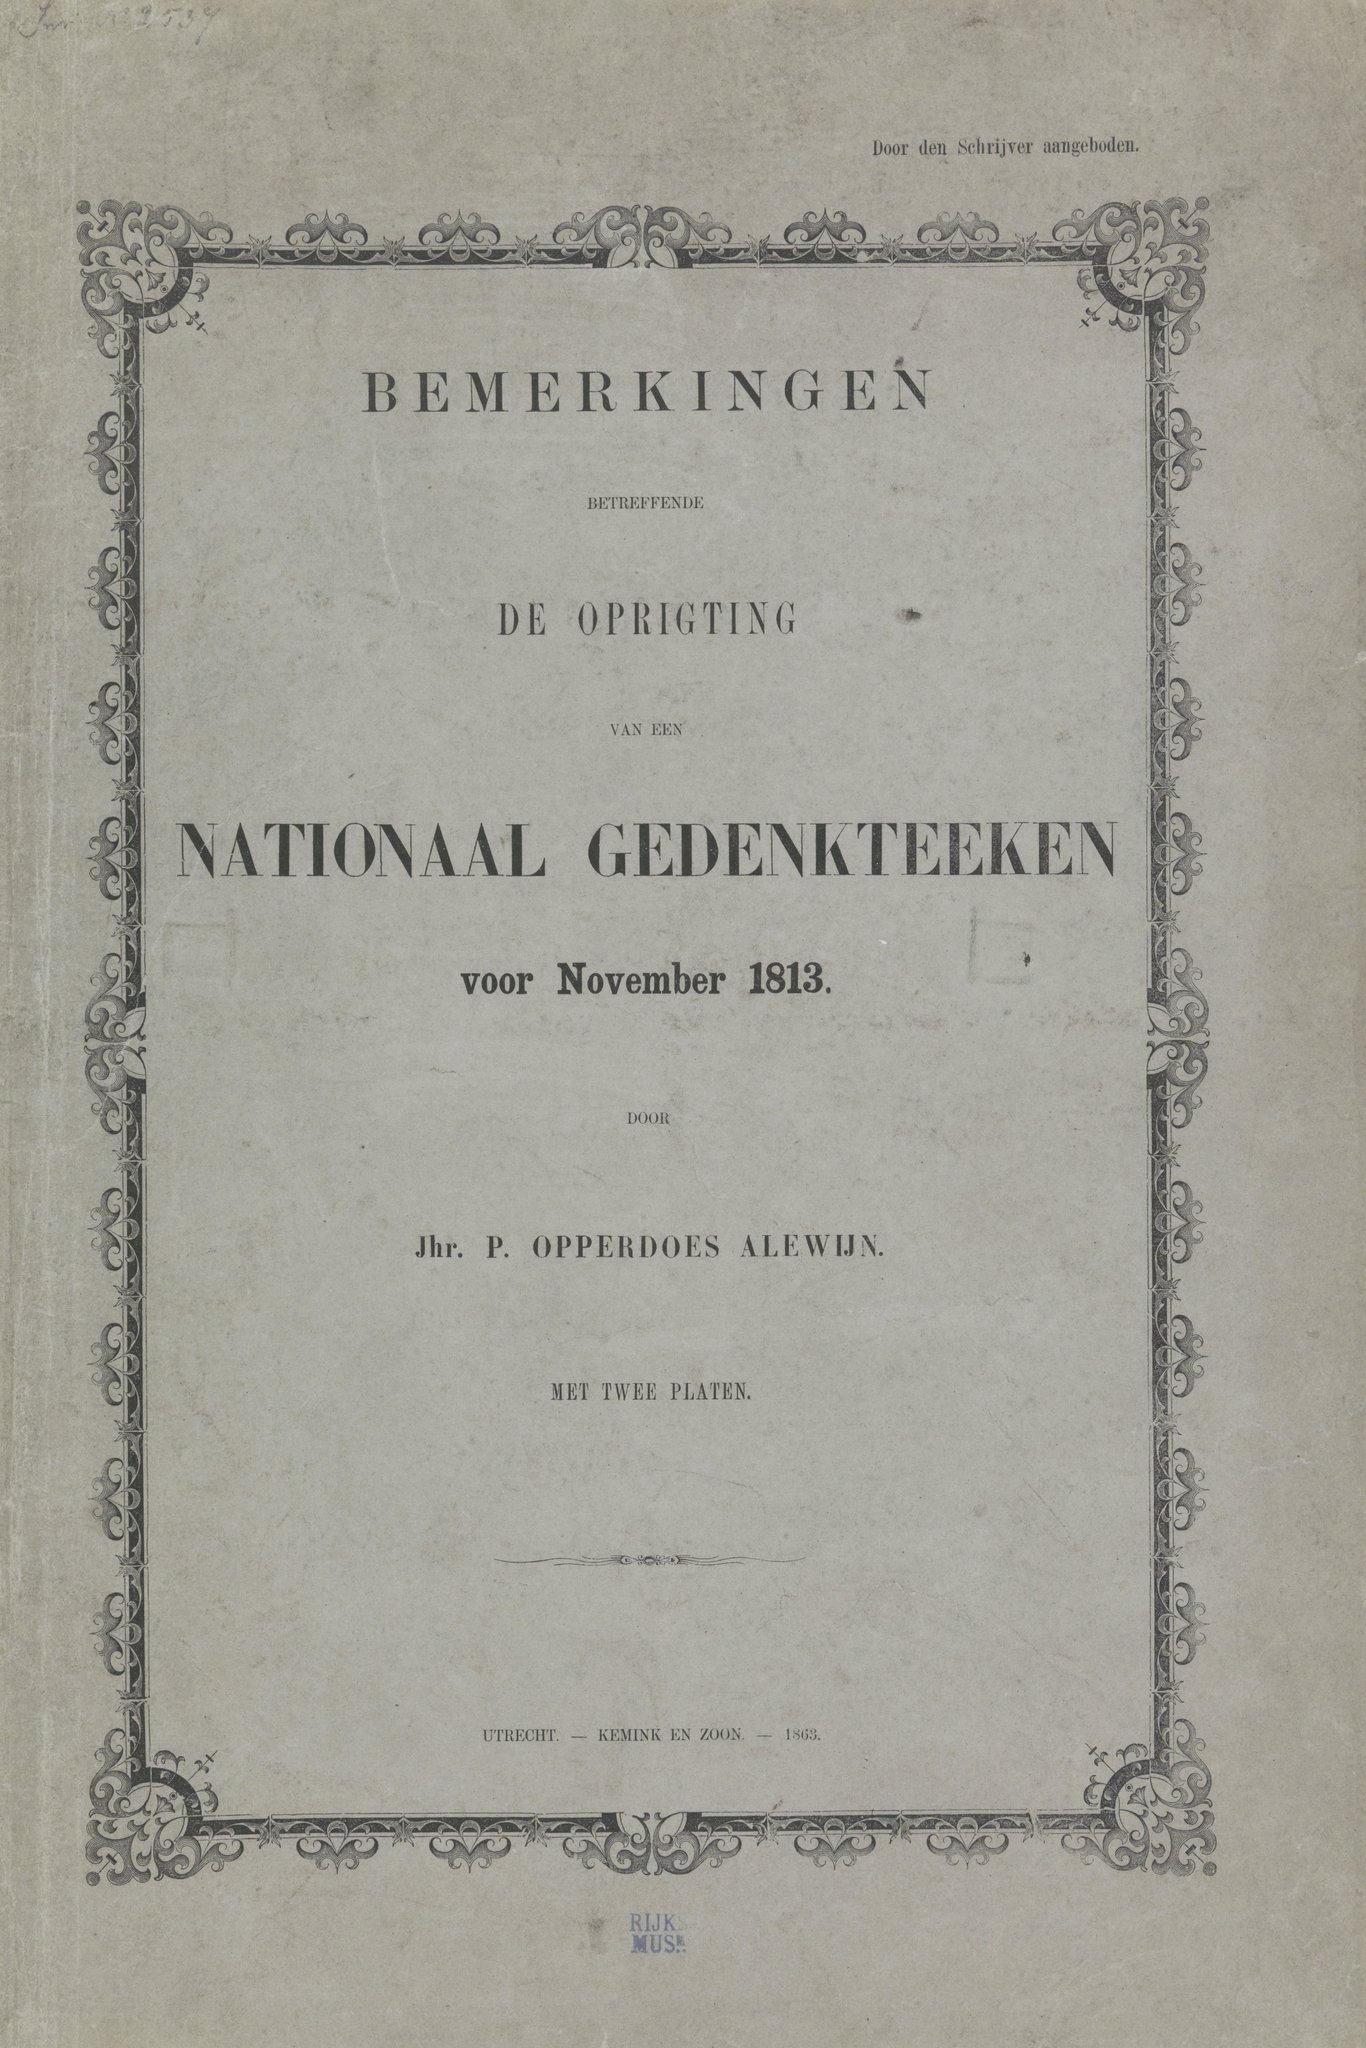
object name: print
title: Titelblad voor: Bemerkingen betreffende de oprigting van een nationaal gedenkteeken voor November 1813. Door Jhr. P. Opperdoes Alewijn, 1863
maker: hendrik vorderman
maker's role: draughtsman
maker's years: 1824-1897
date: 1863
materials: paper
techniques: lithograph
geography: netherlands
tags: berlin, william i of the netherlands, landing of william frederick i (1813)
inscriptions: collector's mark: Lugt 2228, collector's mark: Lugt 2166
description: Los titelblad voor de uitgave: Jhr. P. Opperdoes Alewijn, Bemerkingen betreffende de oprigting van een nationaal gedenkteeken voor November 1813, Utrecht 1863. Titel binnen ornamentele kader.